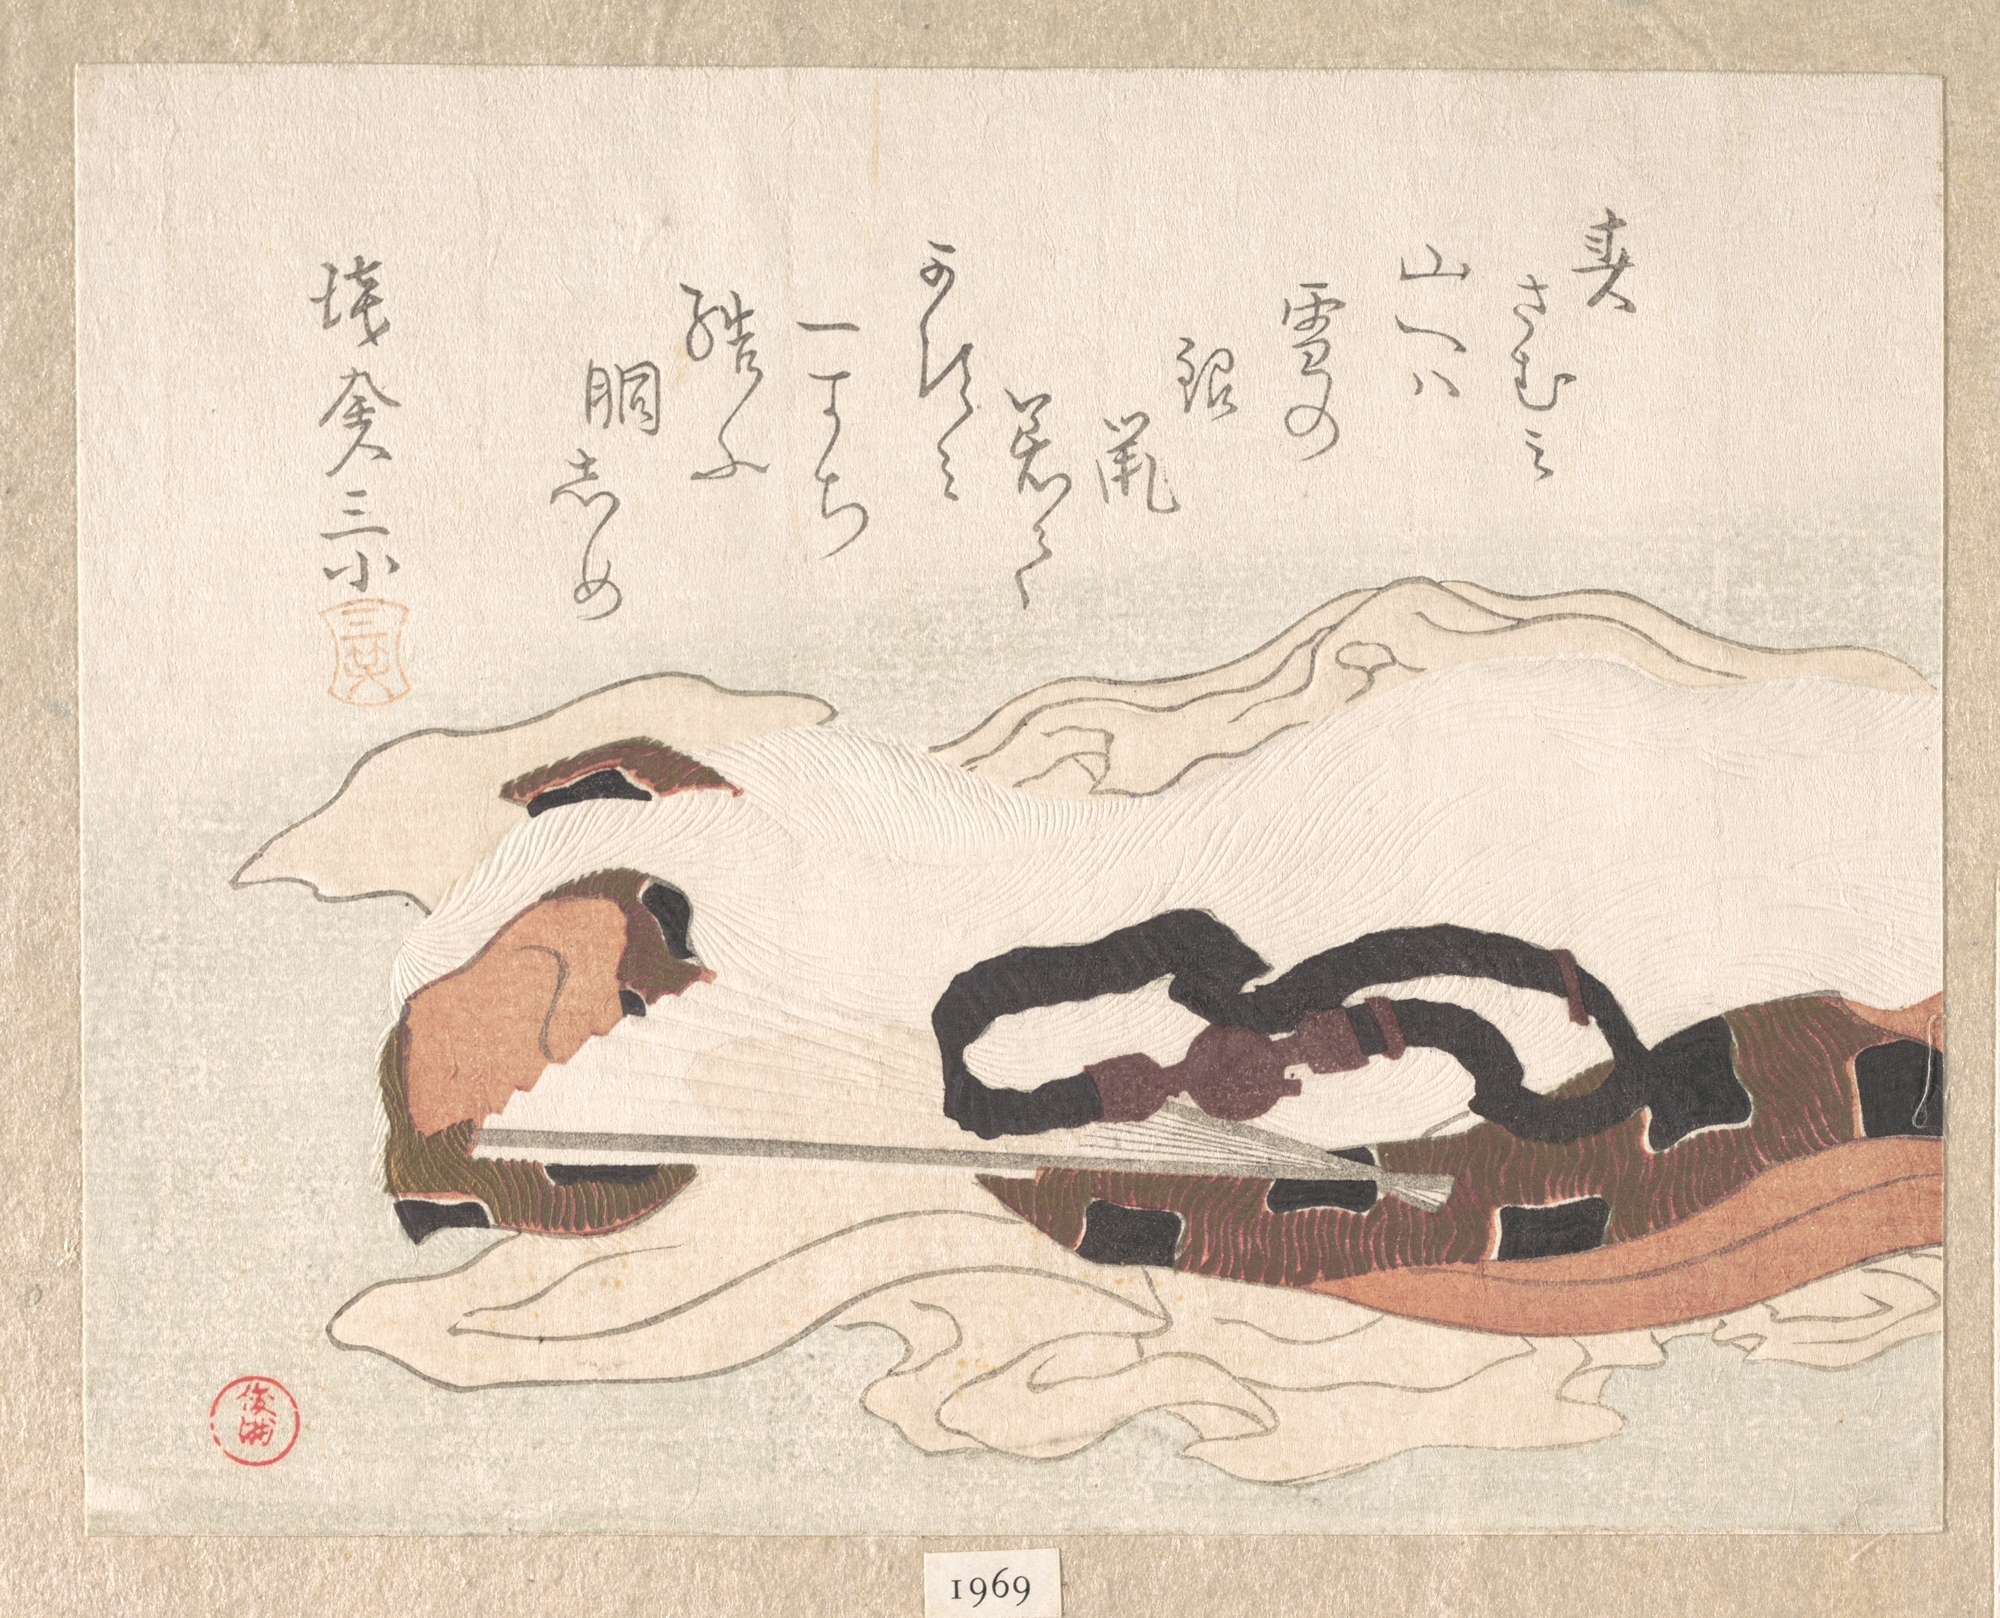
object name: woodblock print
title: Belt and Fan on a Piece of Cloth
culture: japanese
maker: kubo shunman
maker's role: artist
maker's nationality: japanese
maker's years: 1757-1820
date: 1801-1900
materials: ink, paper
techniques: surimono, woodblock print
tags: belts,fans